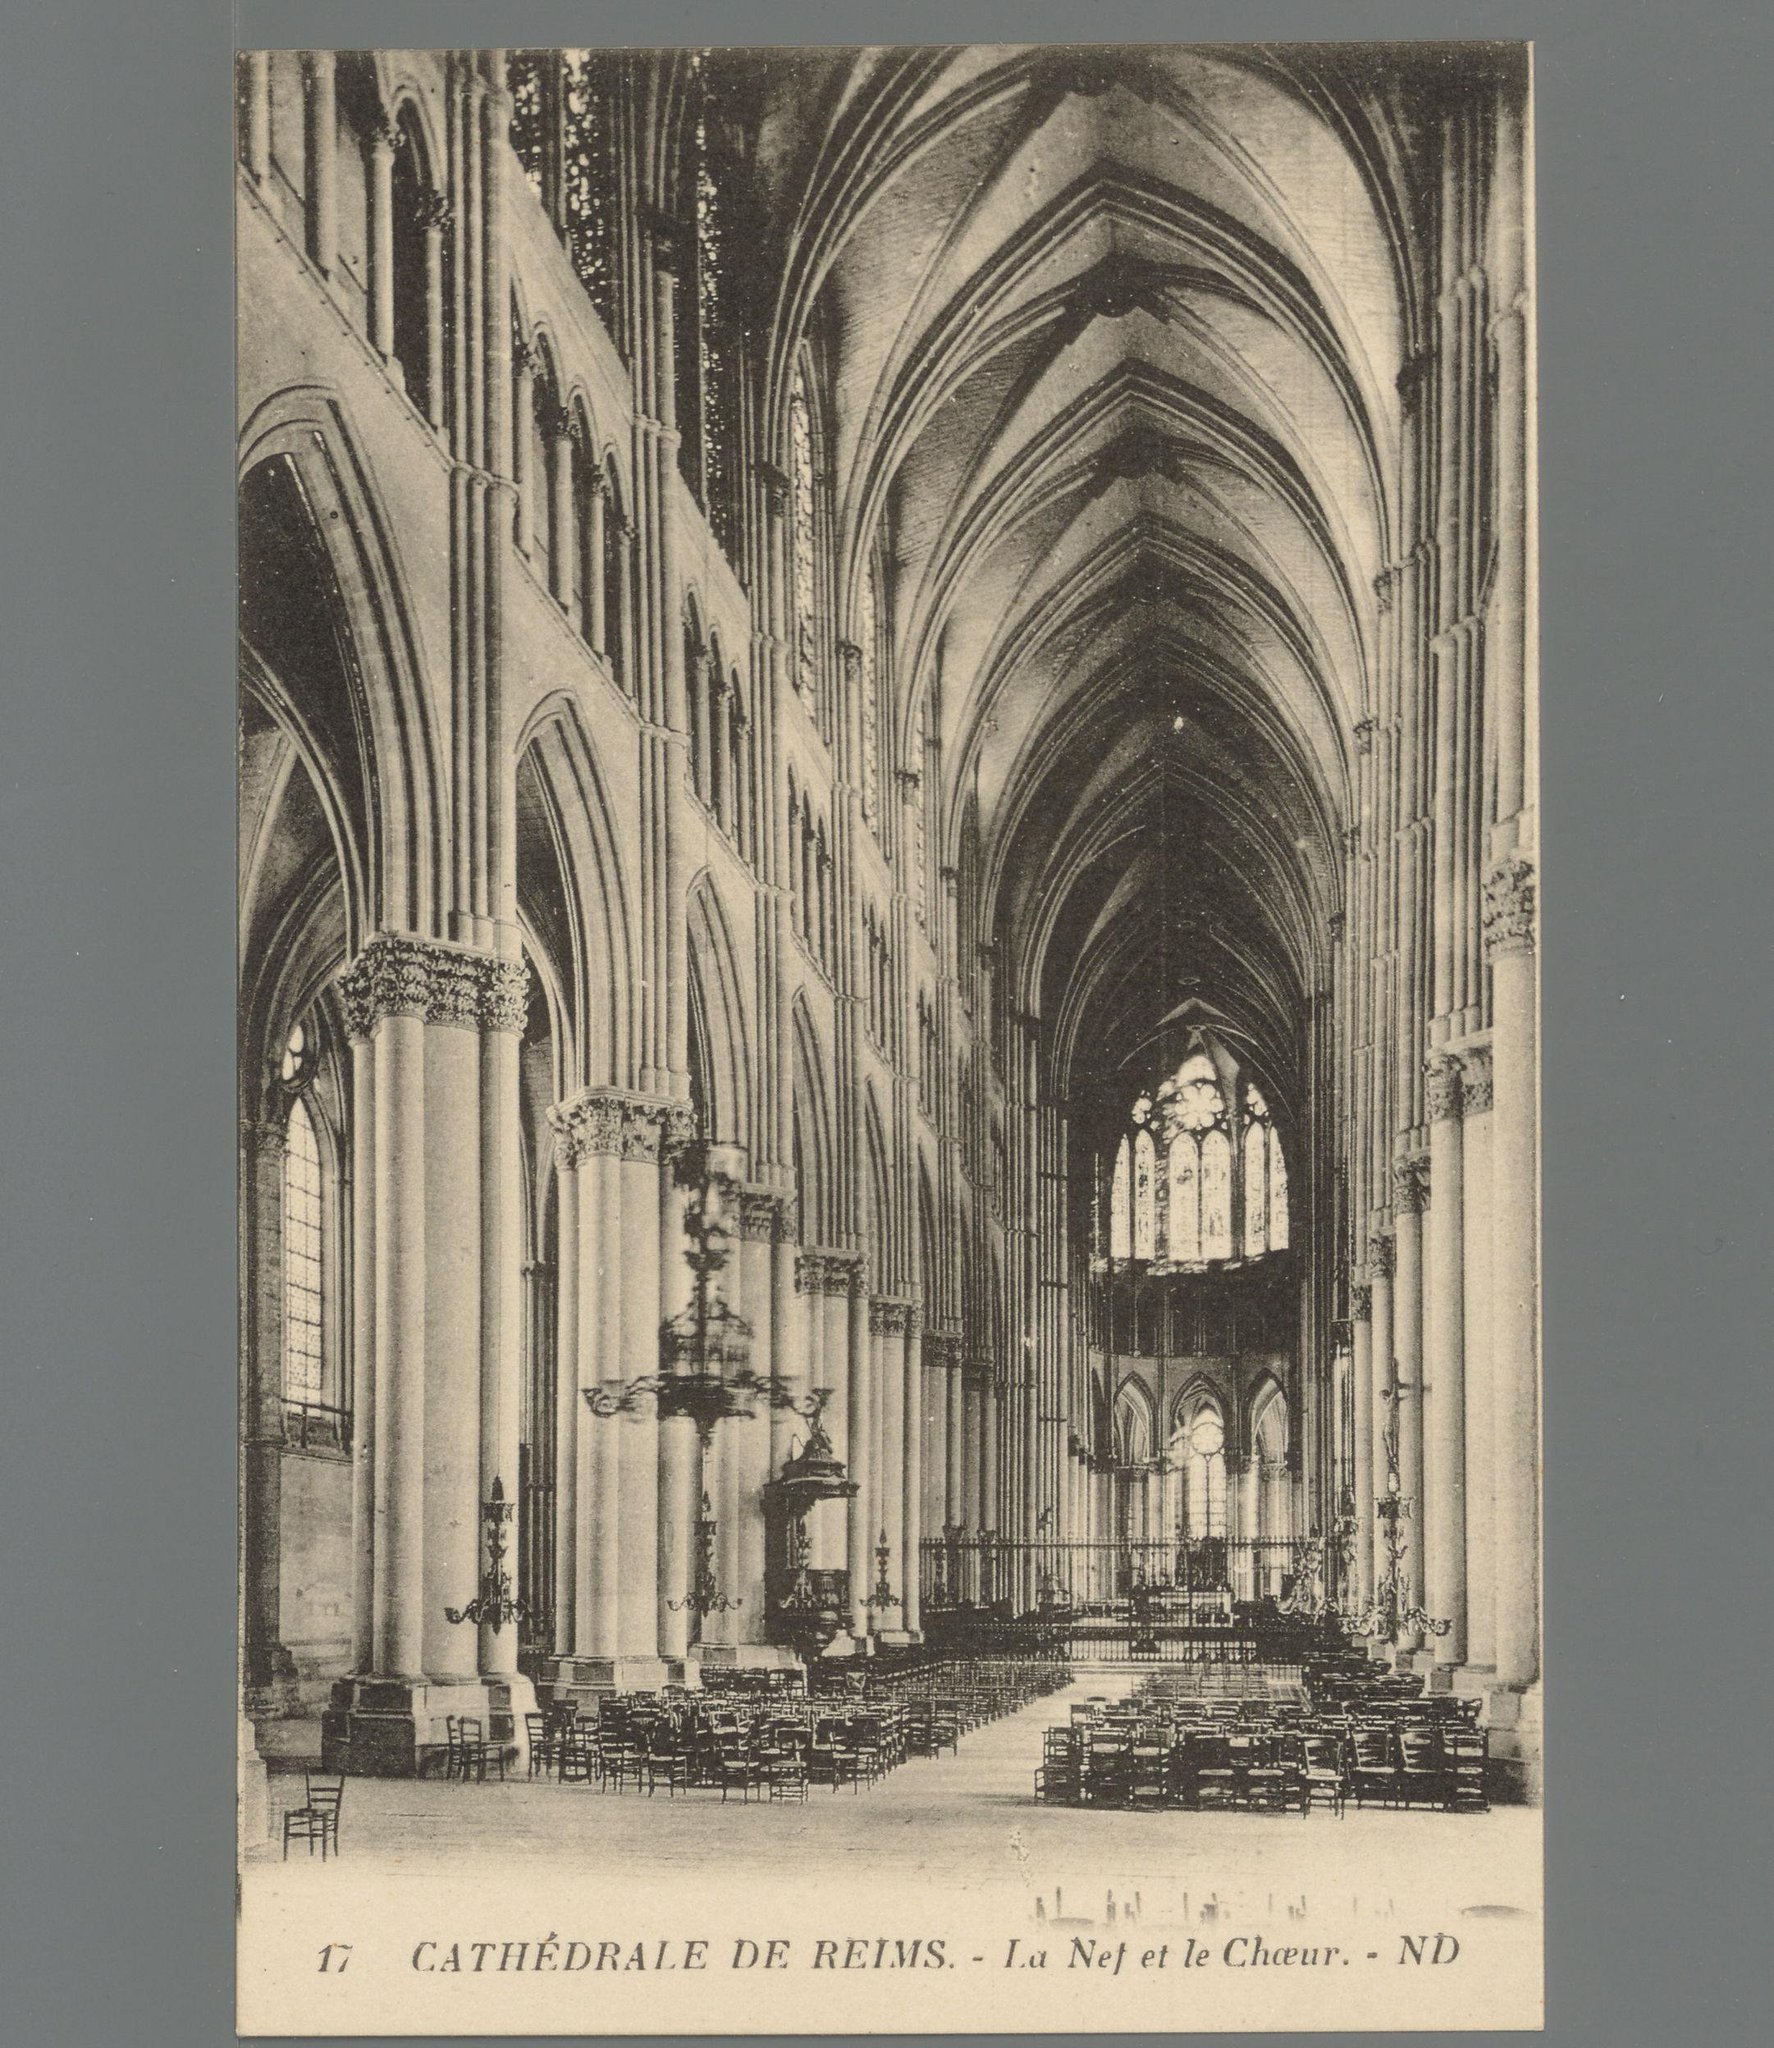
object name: photomechanical print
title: Cathédrale de Reims - La Nef et la Choeur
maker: Anonymous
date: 1920-1932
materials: cardboard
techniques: photograph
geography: paris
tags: parts of church interior: nave, parts of church interior: choir